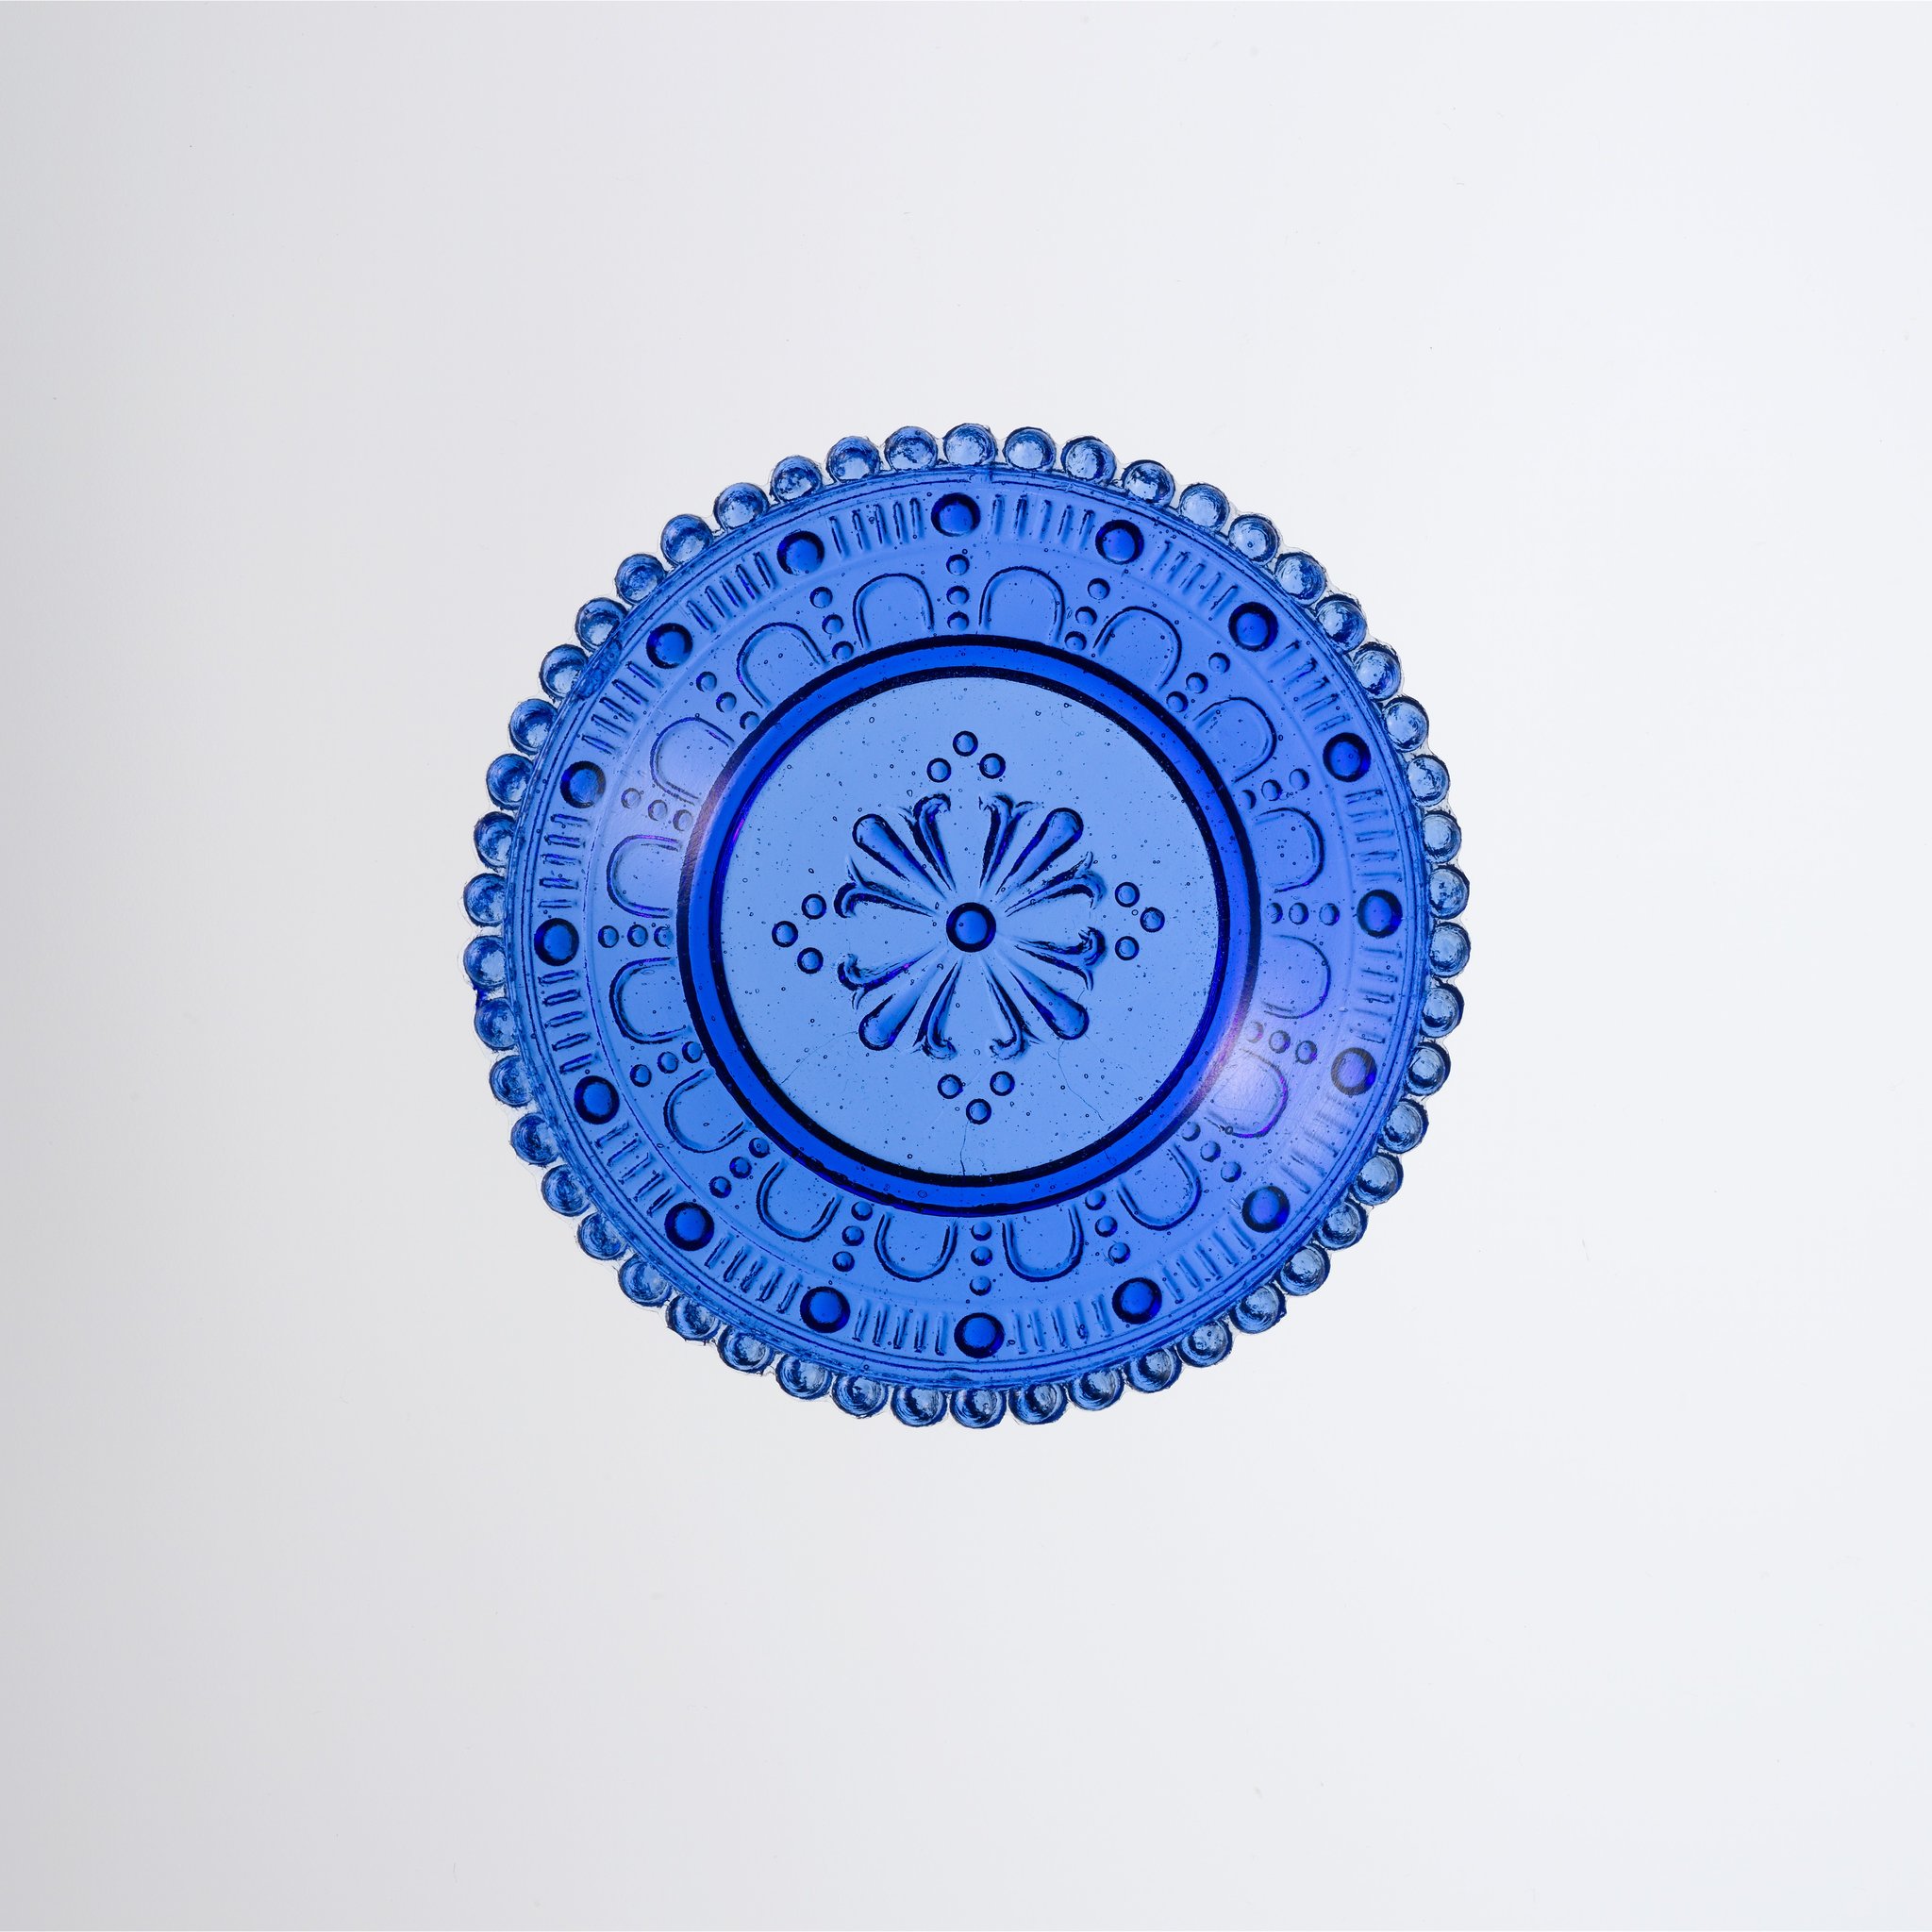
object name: cup plate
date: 1825-1860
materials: glass